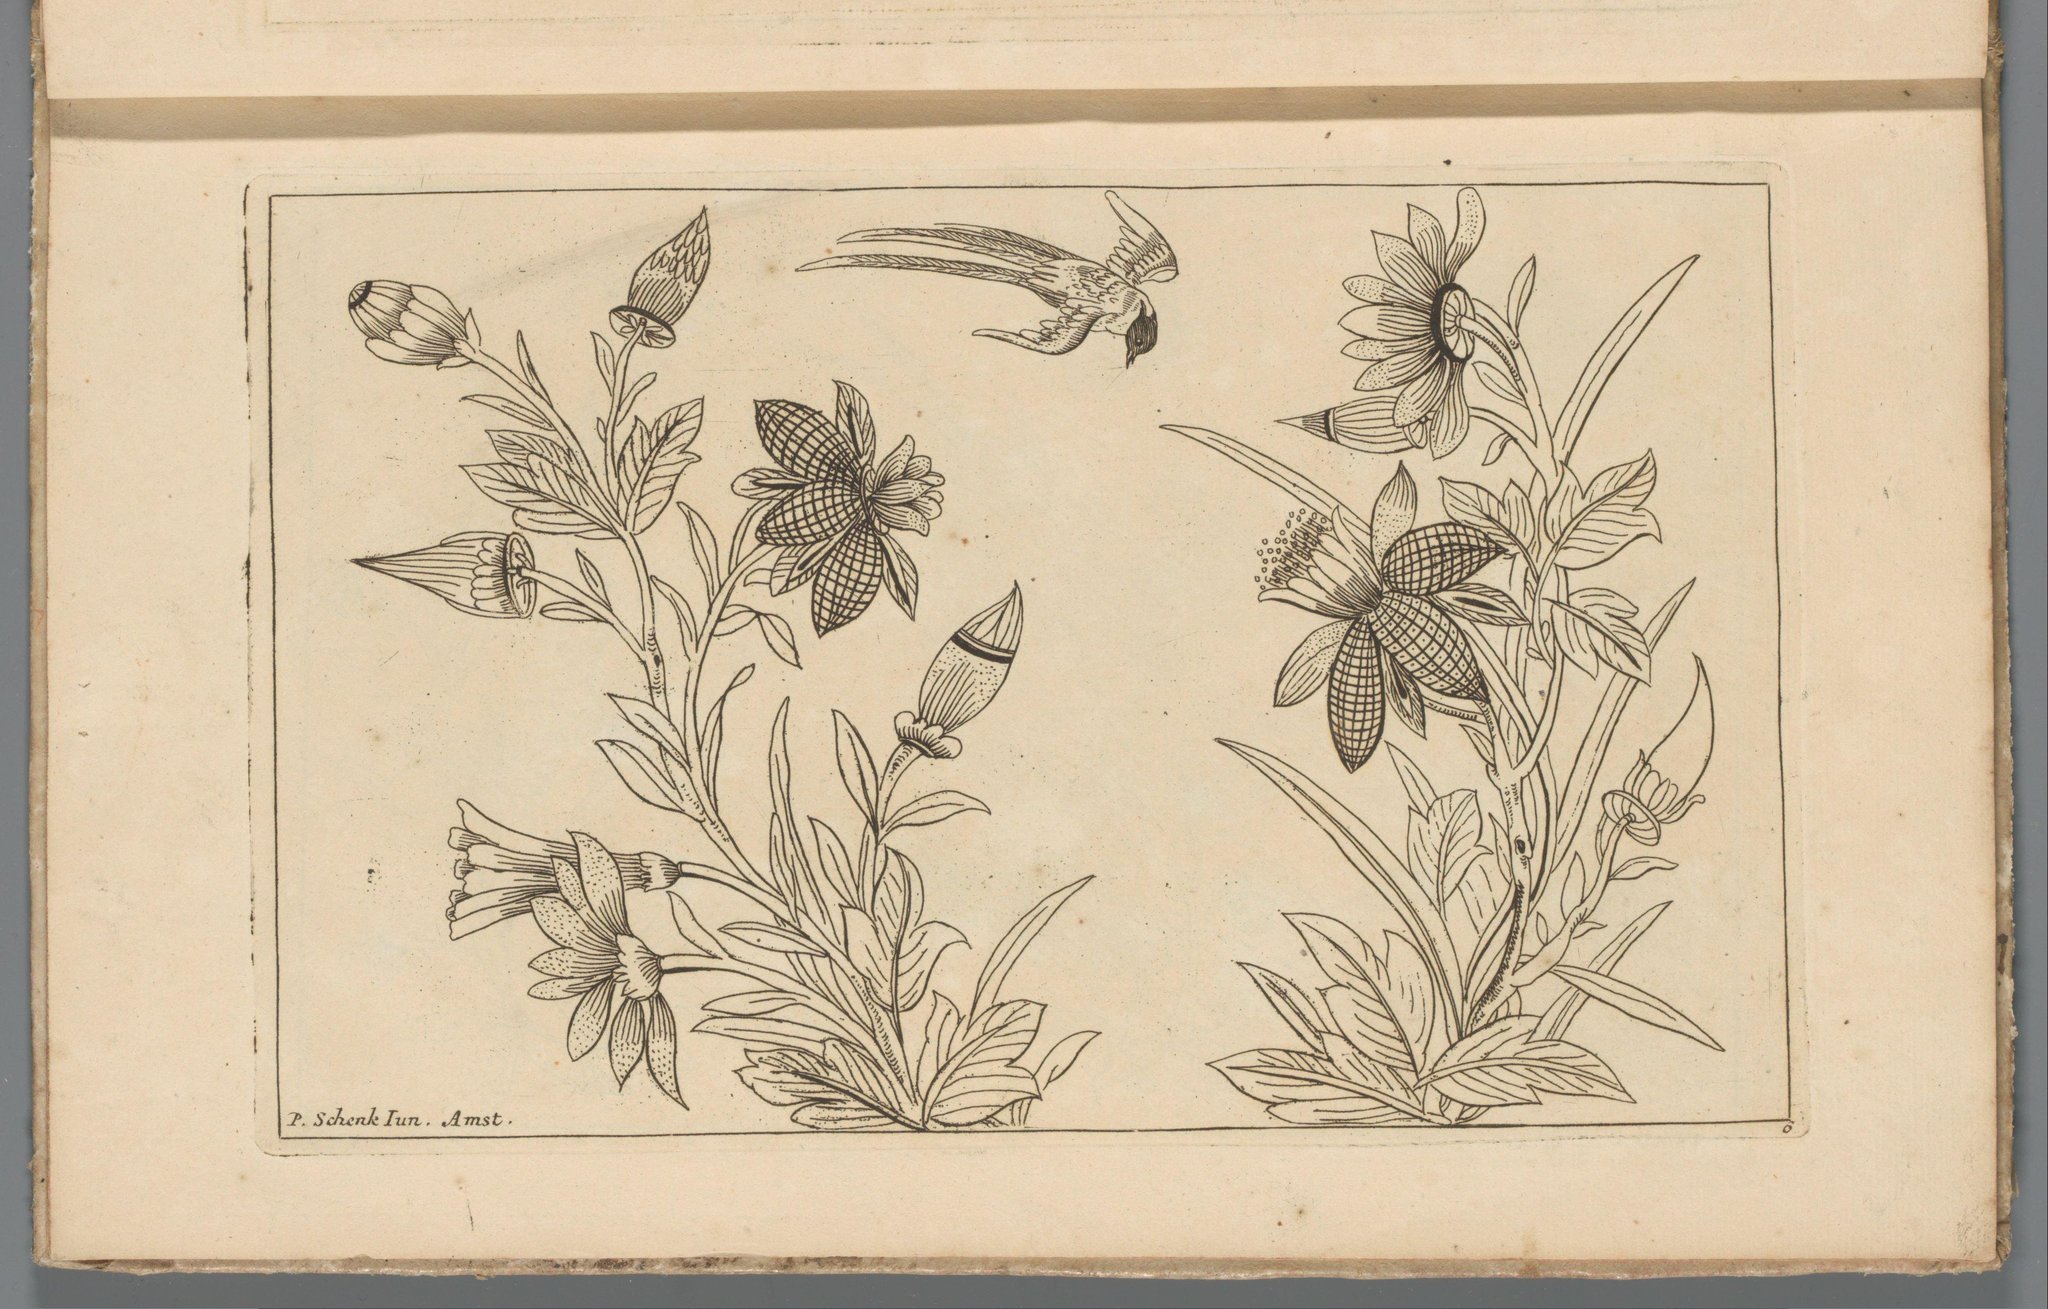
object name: ornament print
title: Twee bloemenstruiken en een zwaluw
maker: pieter schenk (ii)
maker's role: draughtsman, print maker, publisher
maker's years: 1693-1775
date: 1727-1775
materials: paper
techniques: etching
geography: amsterdam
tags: flowers, chinese, song-birds: swallow